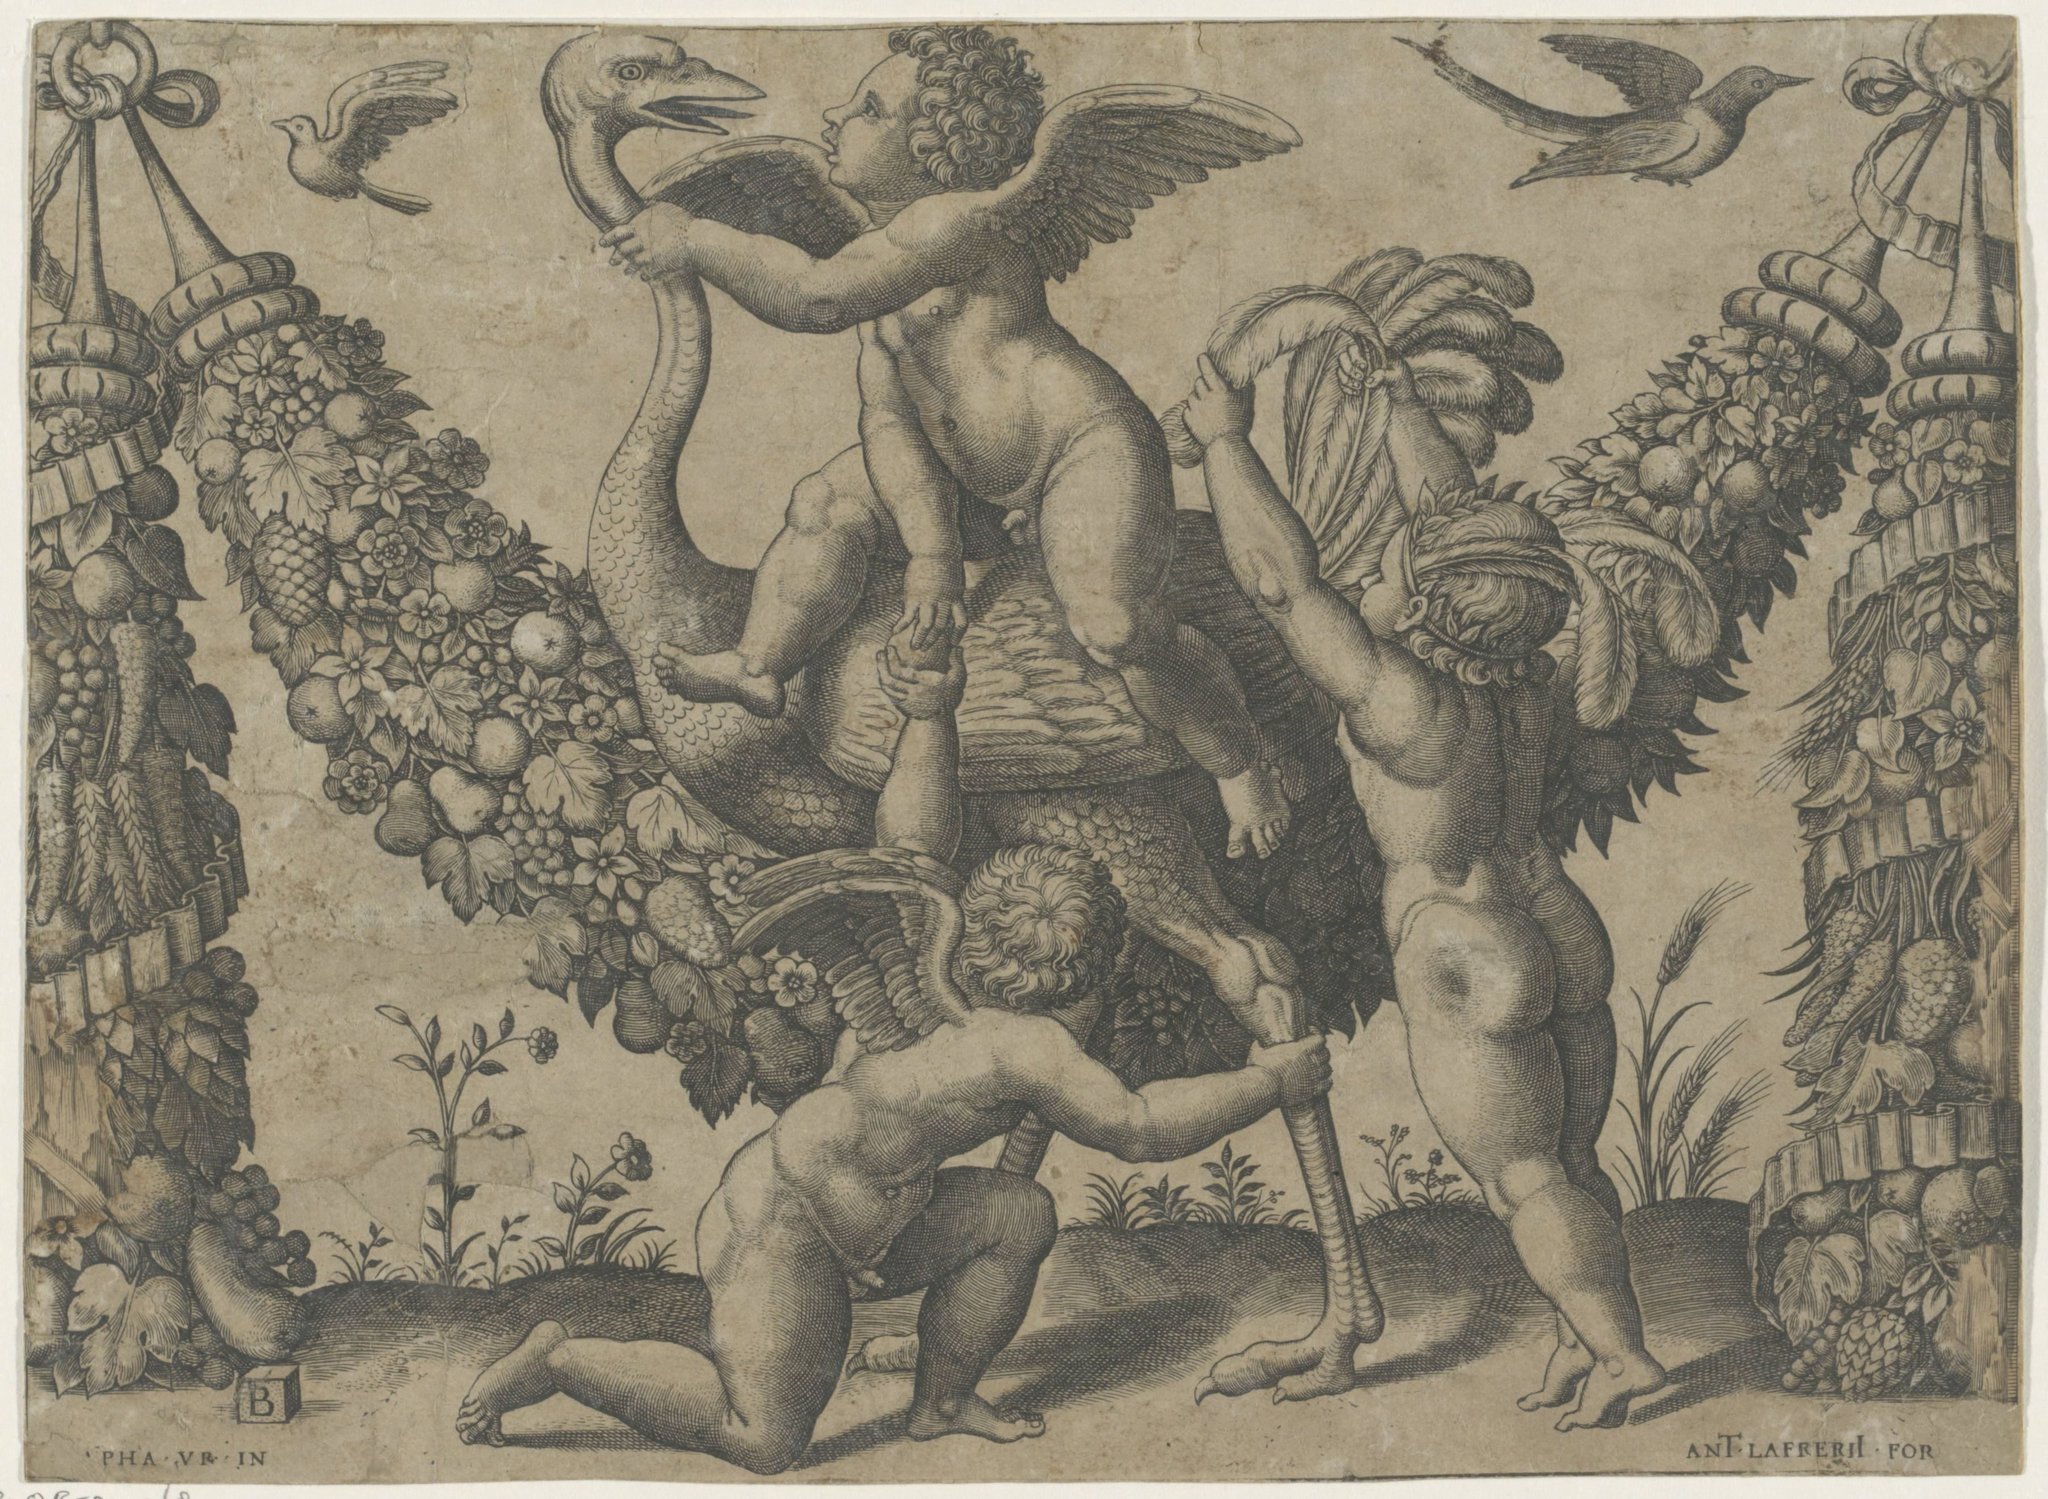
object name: print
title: Wandtapijten van de paus door Rafaël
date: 1530-1570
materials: paper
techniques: engraving, etching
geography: rome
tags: walker and runner birds: ostrich, cupids: 'amores', 'amoretti', 'putti'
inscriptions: collector's mark: Lugt 2228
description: Drie putti houden een struisvogel in bedwang en stelen zijn veren. Achter de struisvogel een grote guirlande met fuit en bloemen.